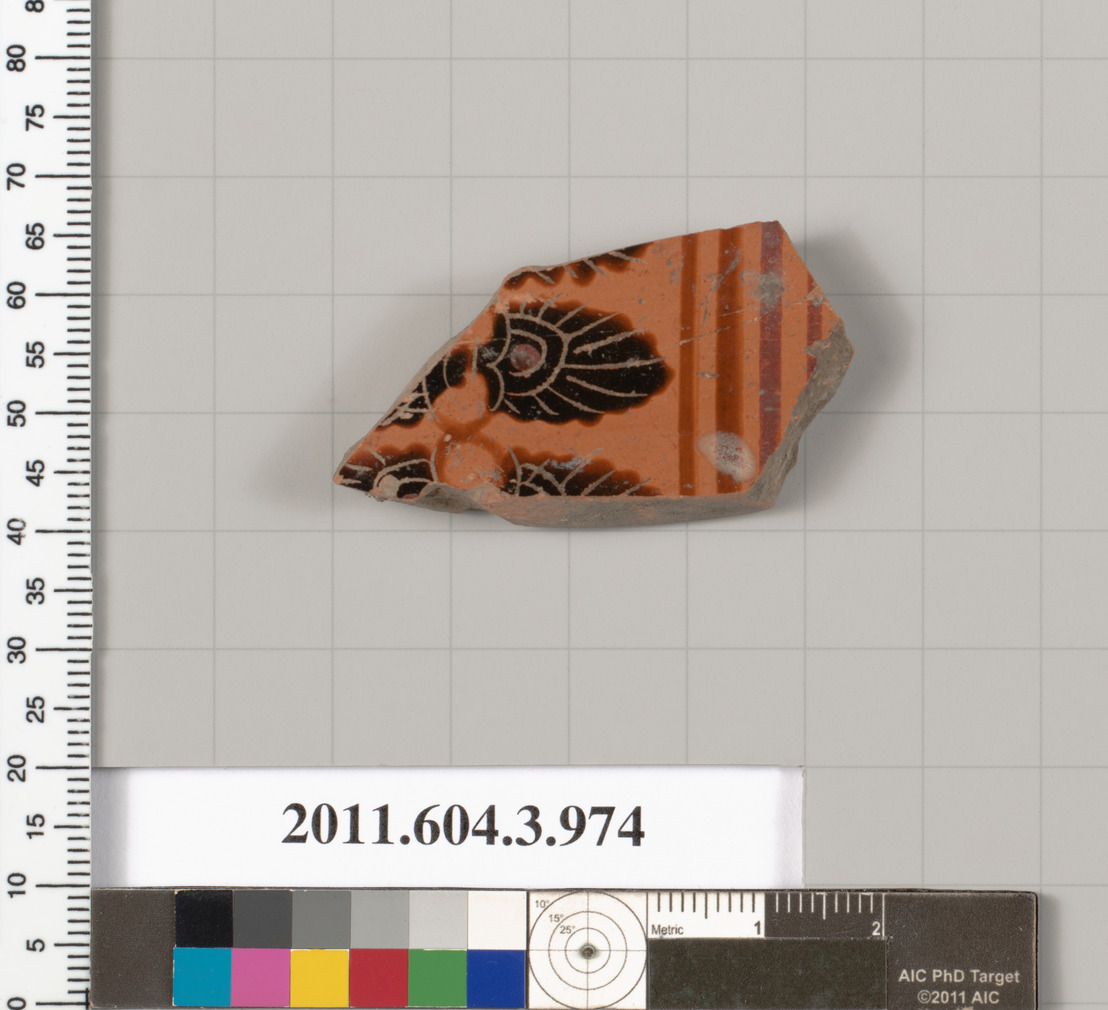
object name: lekanis lid fragment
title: Terracotta fragment of a lekanis lid (covered dish)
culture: greek, attic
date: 575-551 BCE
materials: terracotta